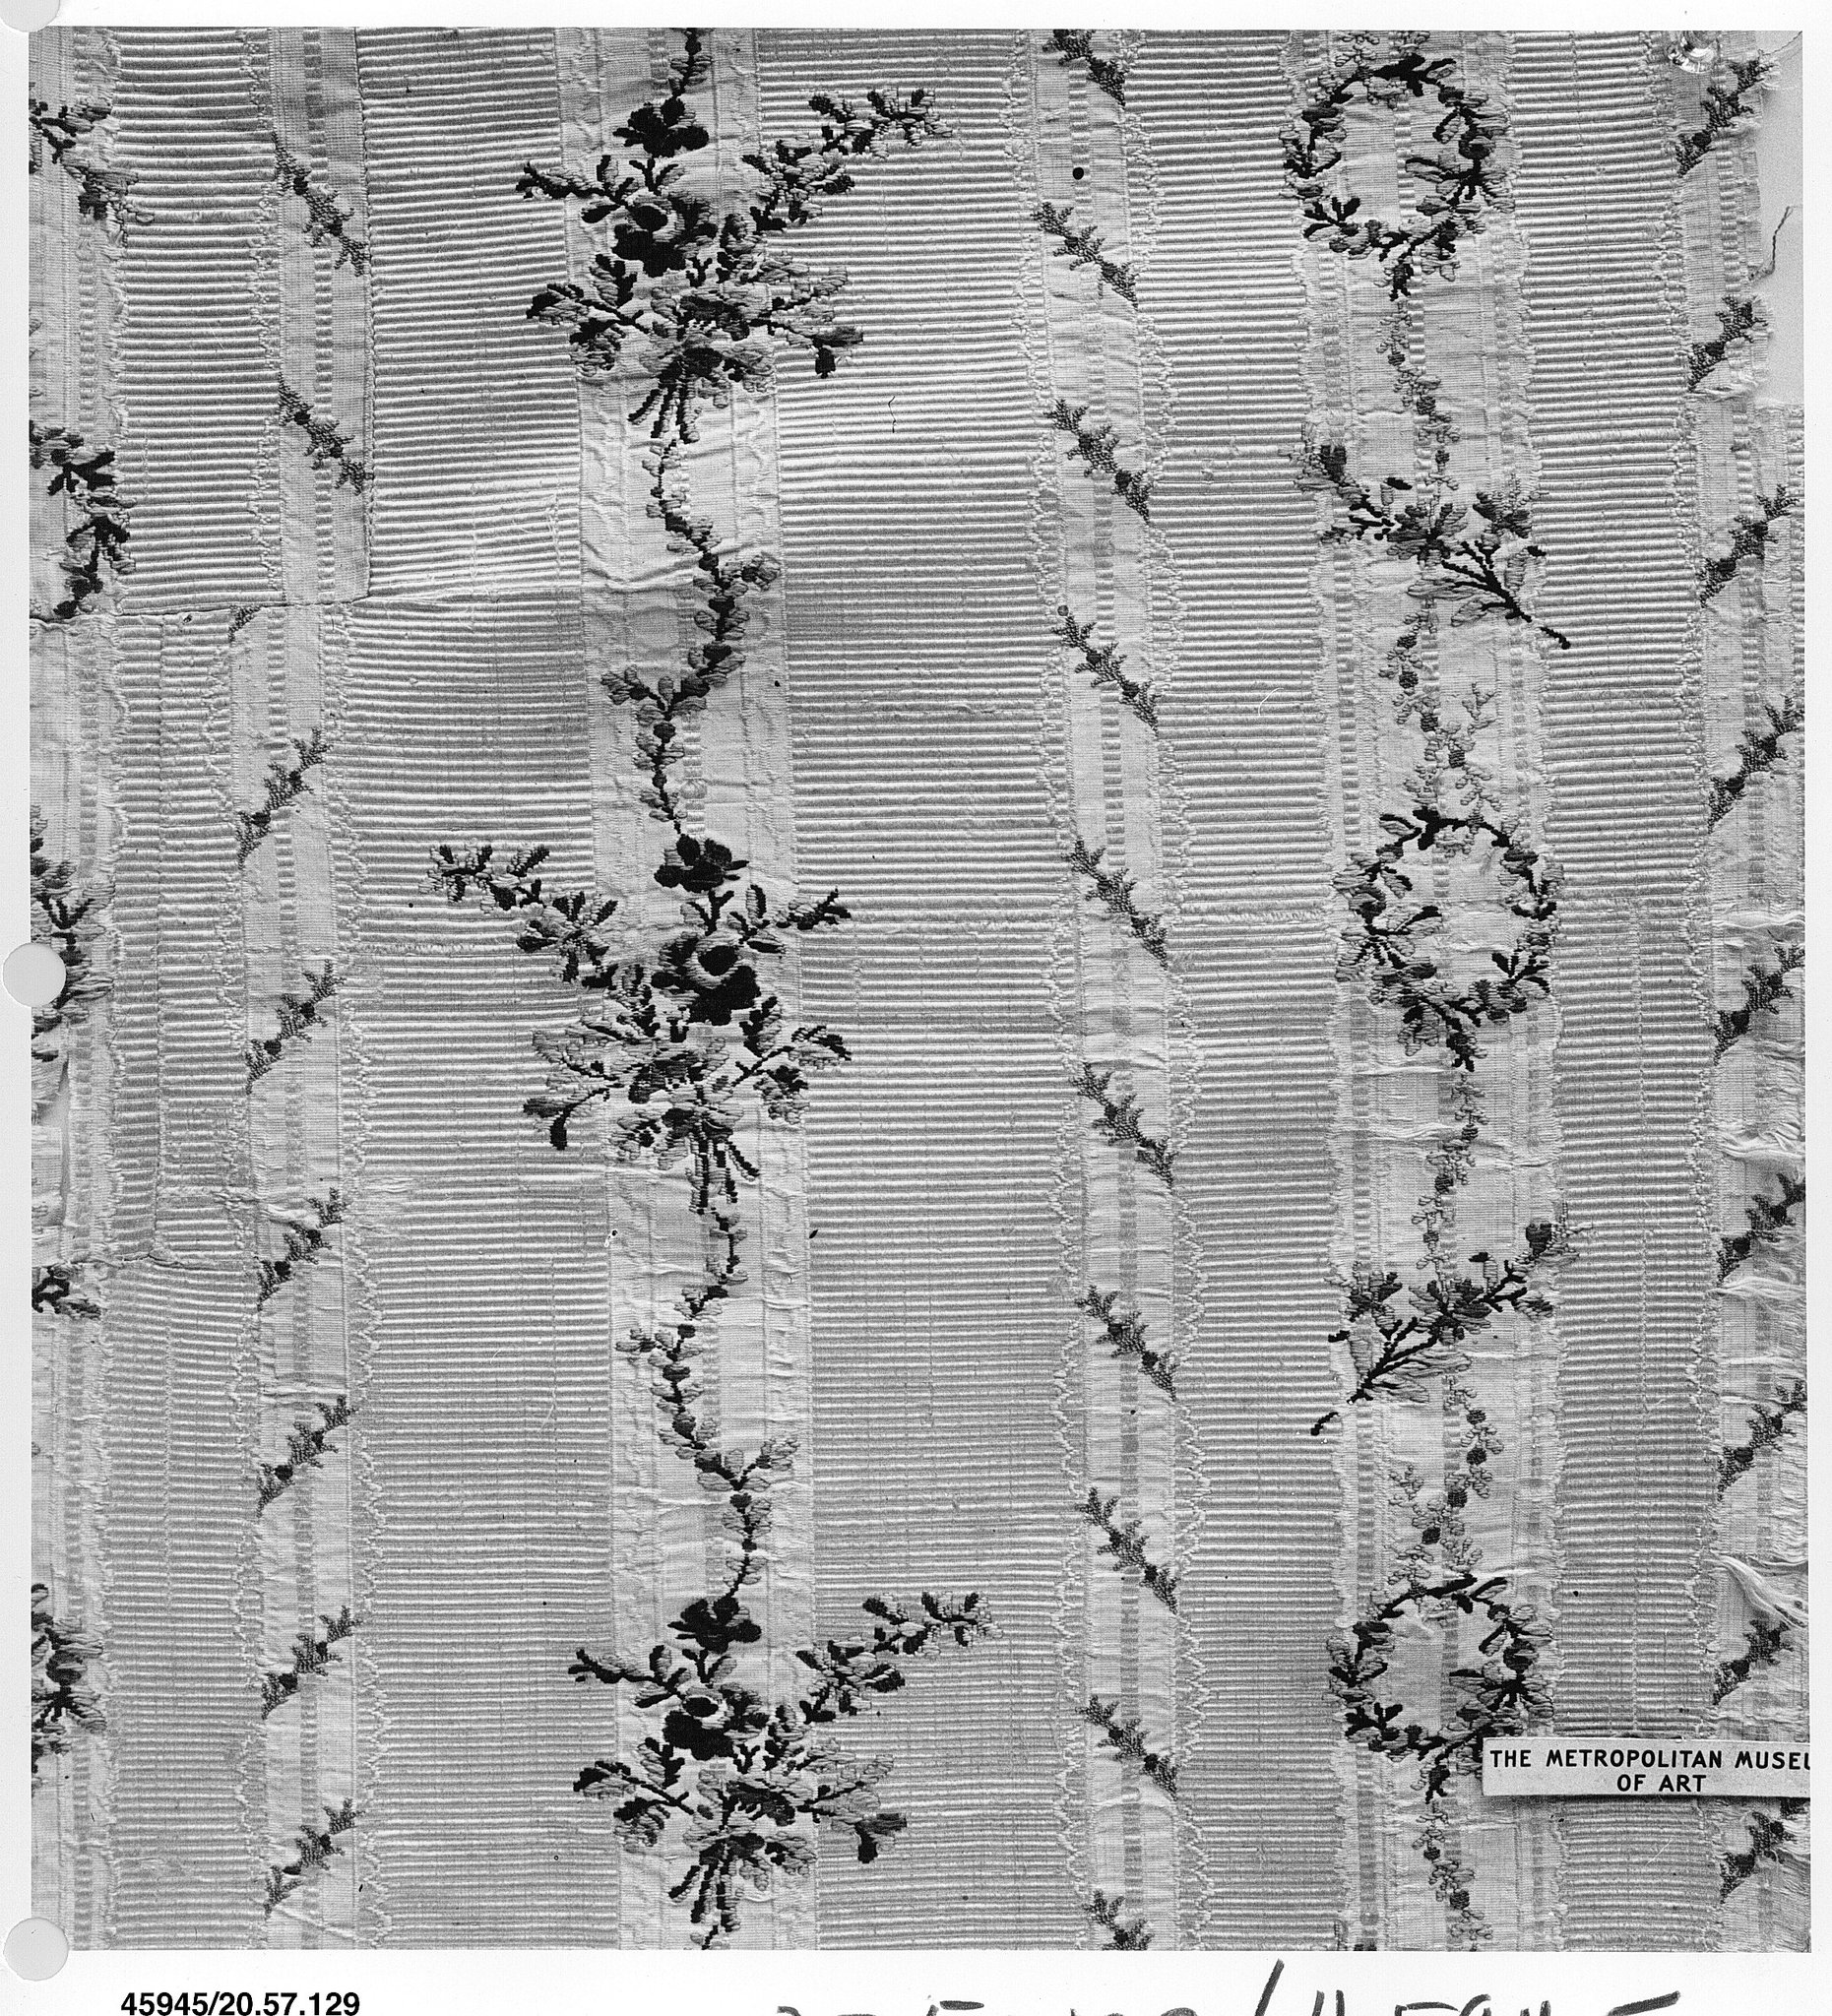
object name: piece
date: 1701-1800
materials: silk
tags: flowers,leaves